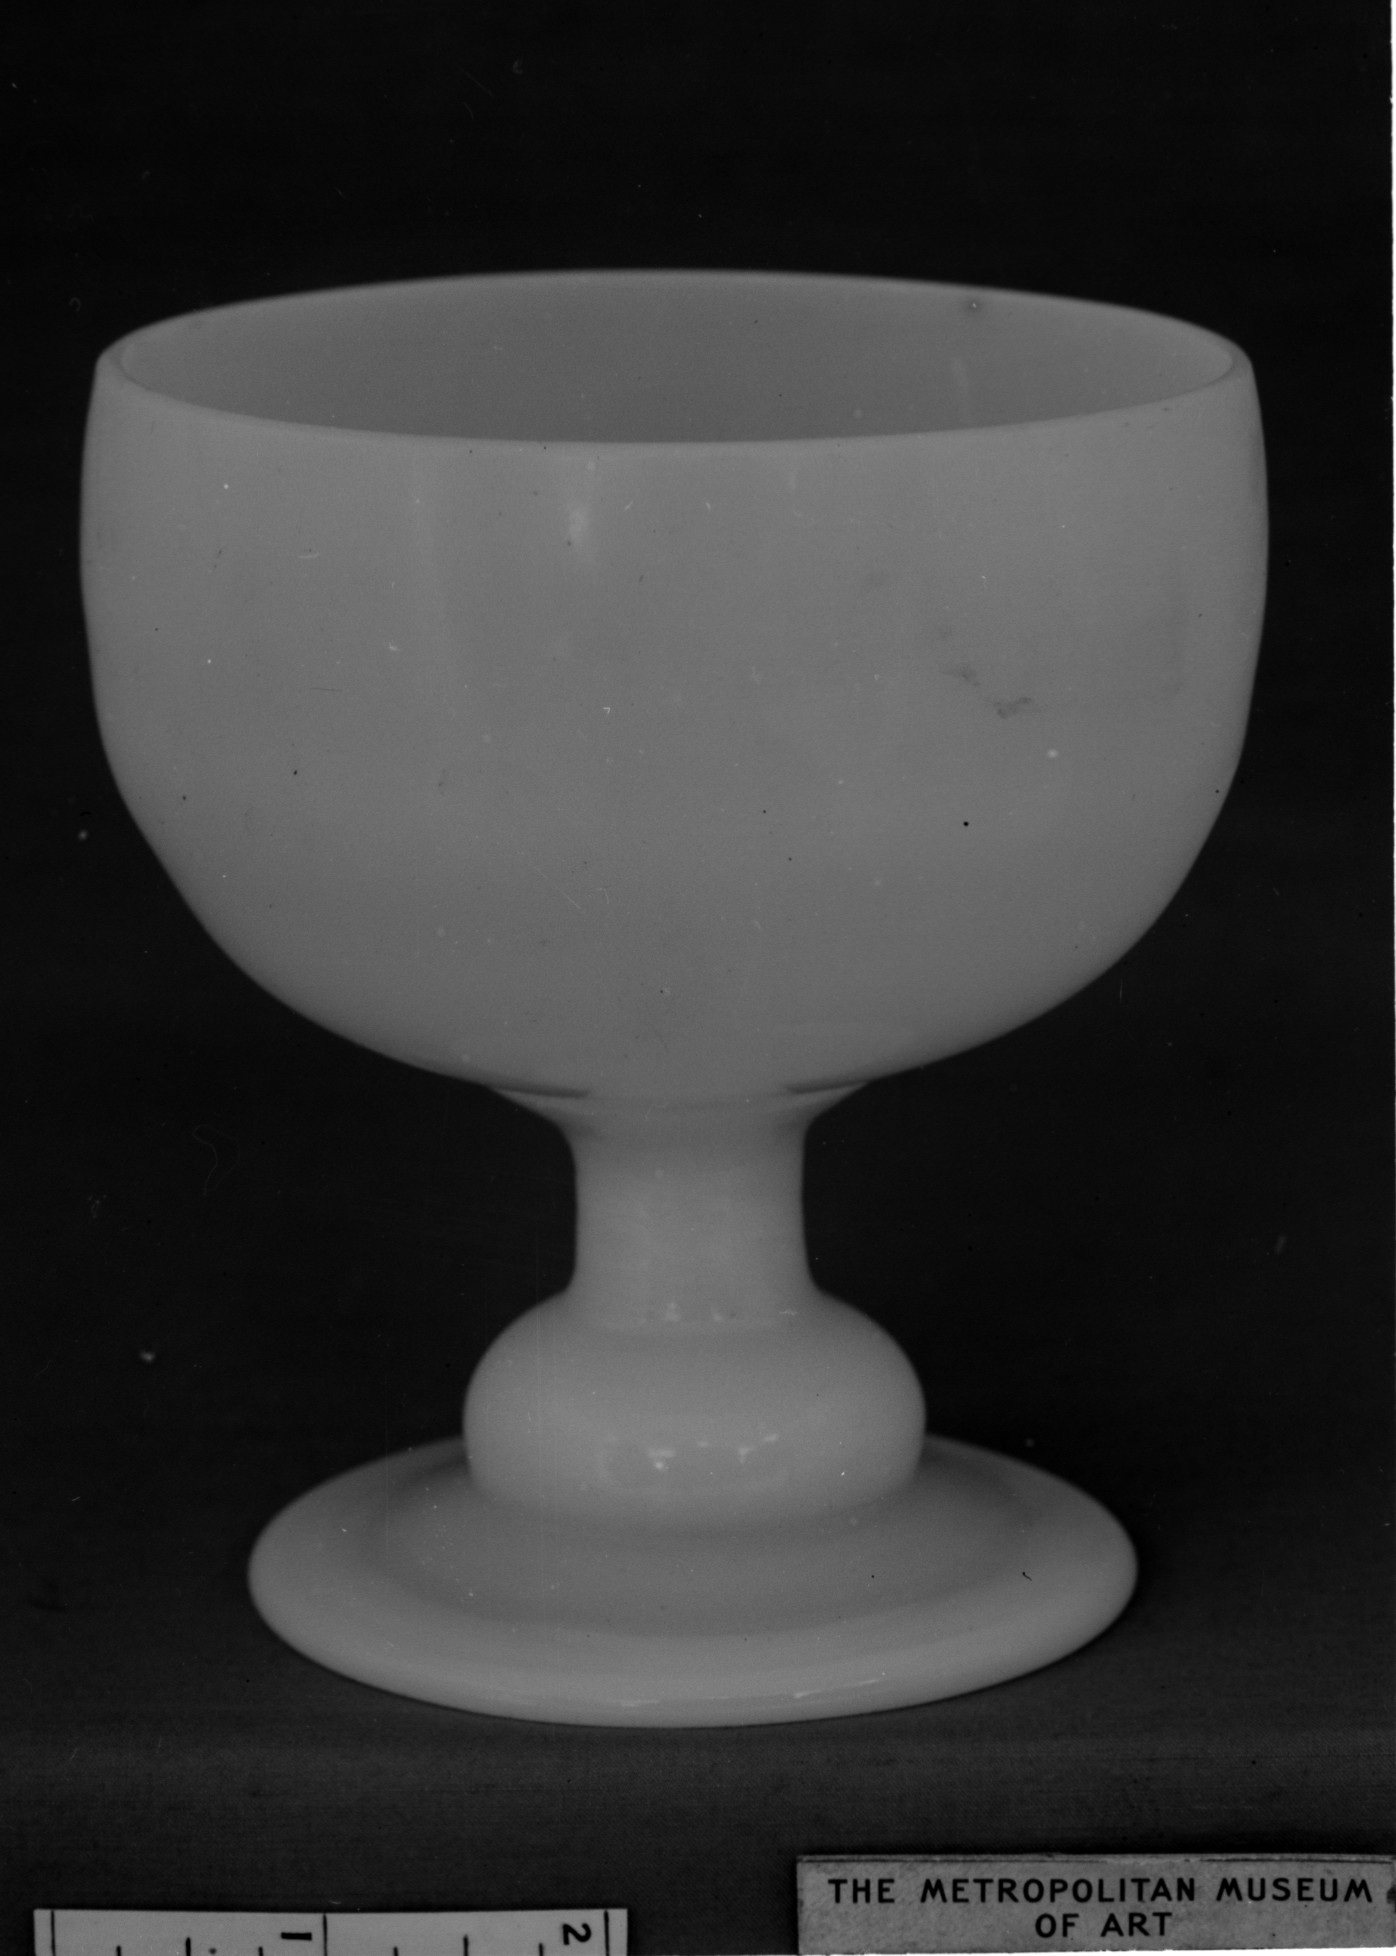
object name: goblet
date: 1701-1800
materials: glass